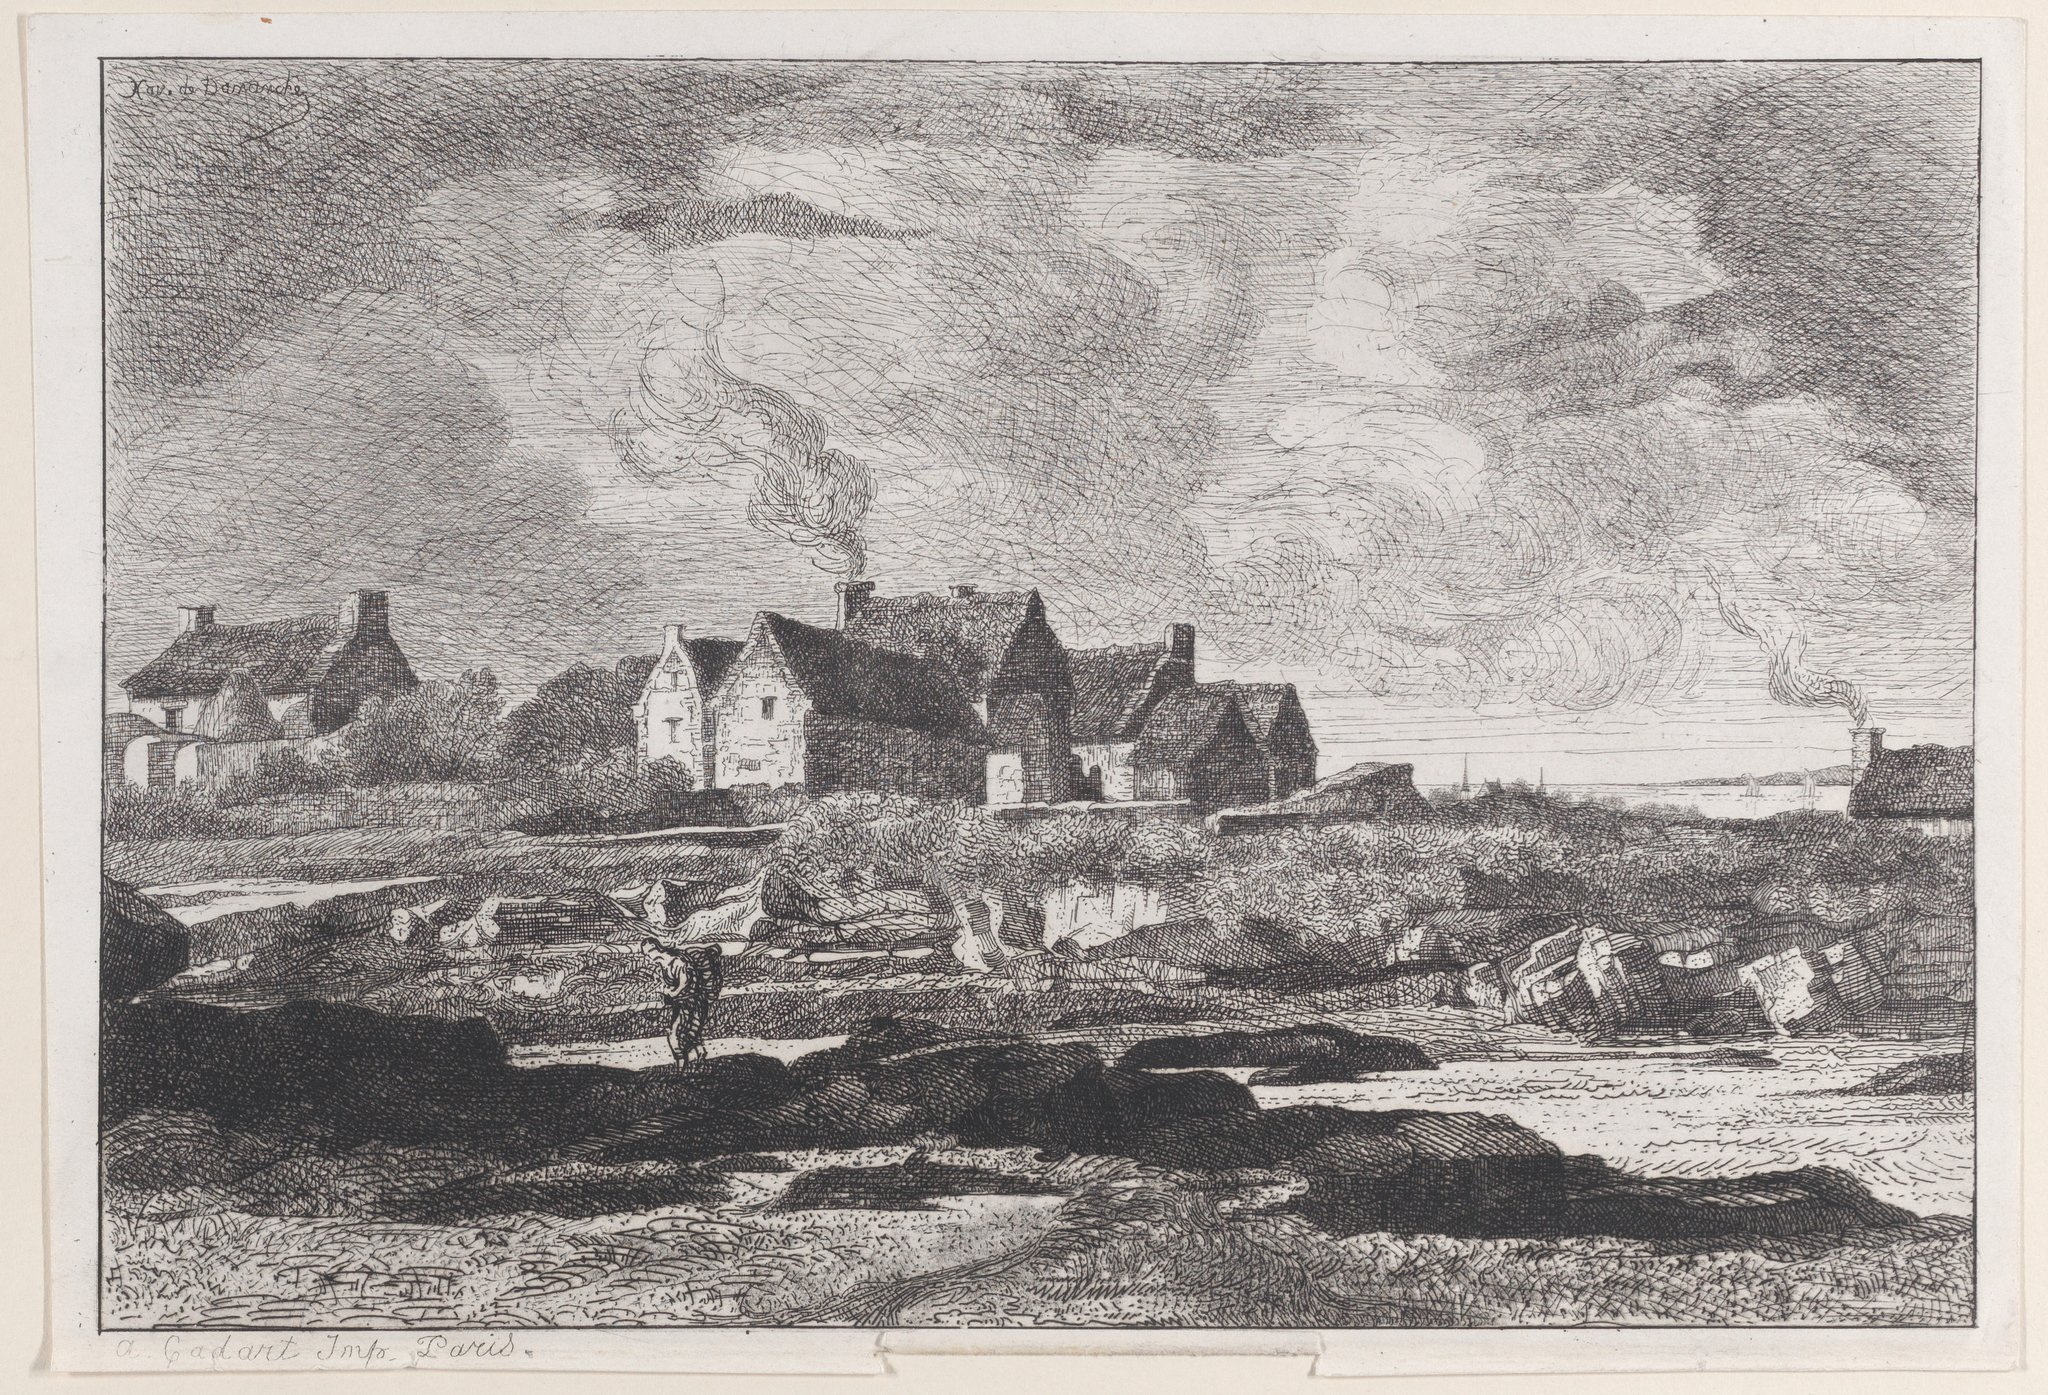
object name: print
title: Country landscape with a river running at right and houses in the background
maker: xavier de dananche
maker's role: artist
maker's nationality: french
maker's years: 1828-1894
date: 1845-1875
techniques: etching